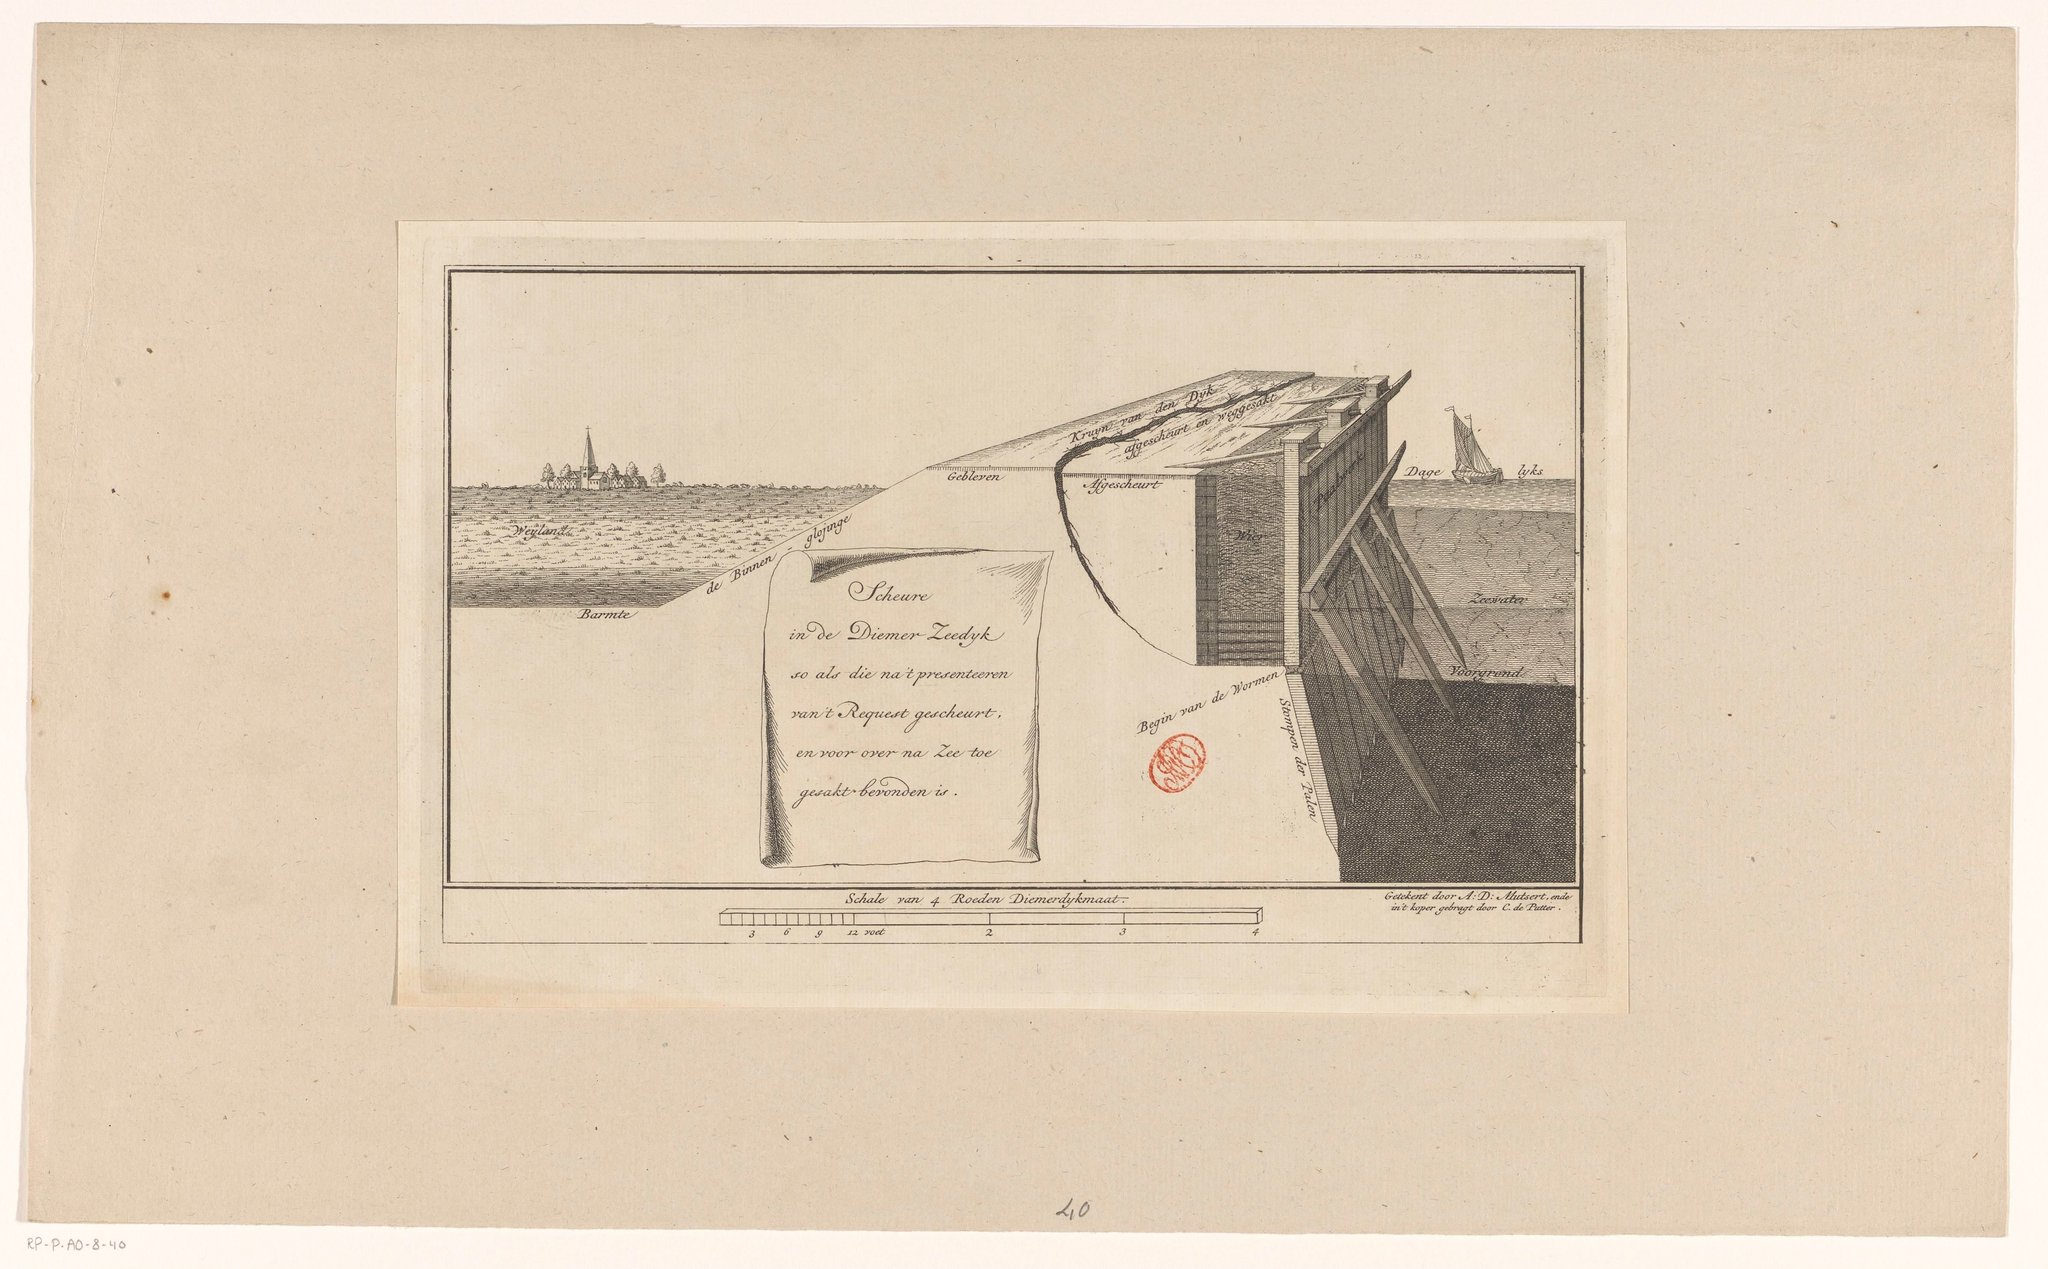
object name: print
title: Profiel van de Diemerzeedijk met scheur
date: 1729-1737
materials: paper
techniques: engraving, etching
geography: amsterdam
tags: dike-break, prospect of village, silhouette of village, sailing-ship, sailing-boat, dikes, levee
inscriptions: collector's mark: Lugt 195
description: Rond 1730 waren de houten palen van de Diemerzeedijk ernstig aangetast door paalworm. In 1737 zouden de houten palen worden vervangen door stenen. Landmeter A.D. Mutsert maakte een aantal tekeningen van de toenmalige Diemerzeedijk en Diemerlanddijk en mogelijke verbeteringen, waarvan ook prenten zijn gemaakt. De huidige prent is daar een van. Zie ook RP-P-AO-8-38 en RP-P-AO-8-39.